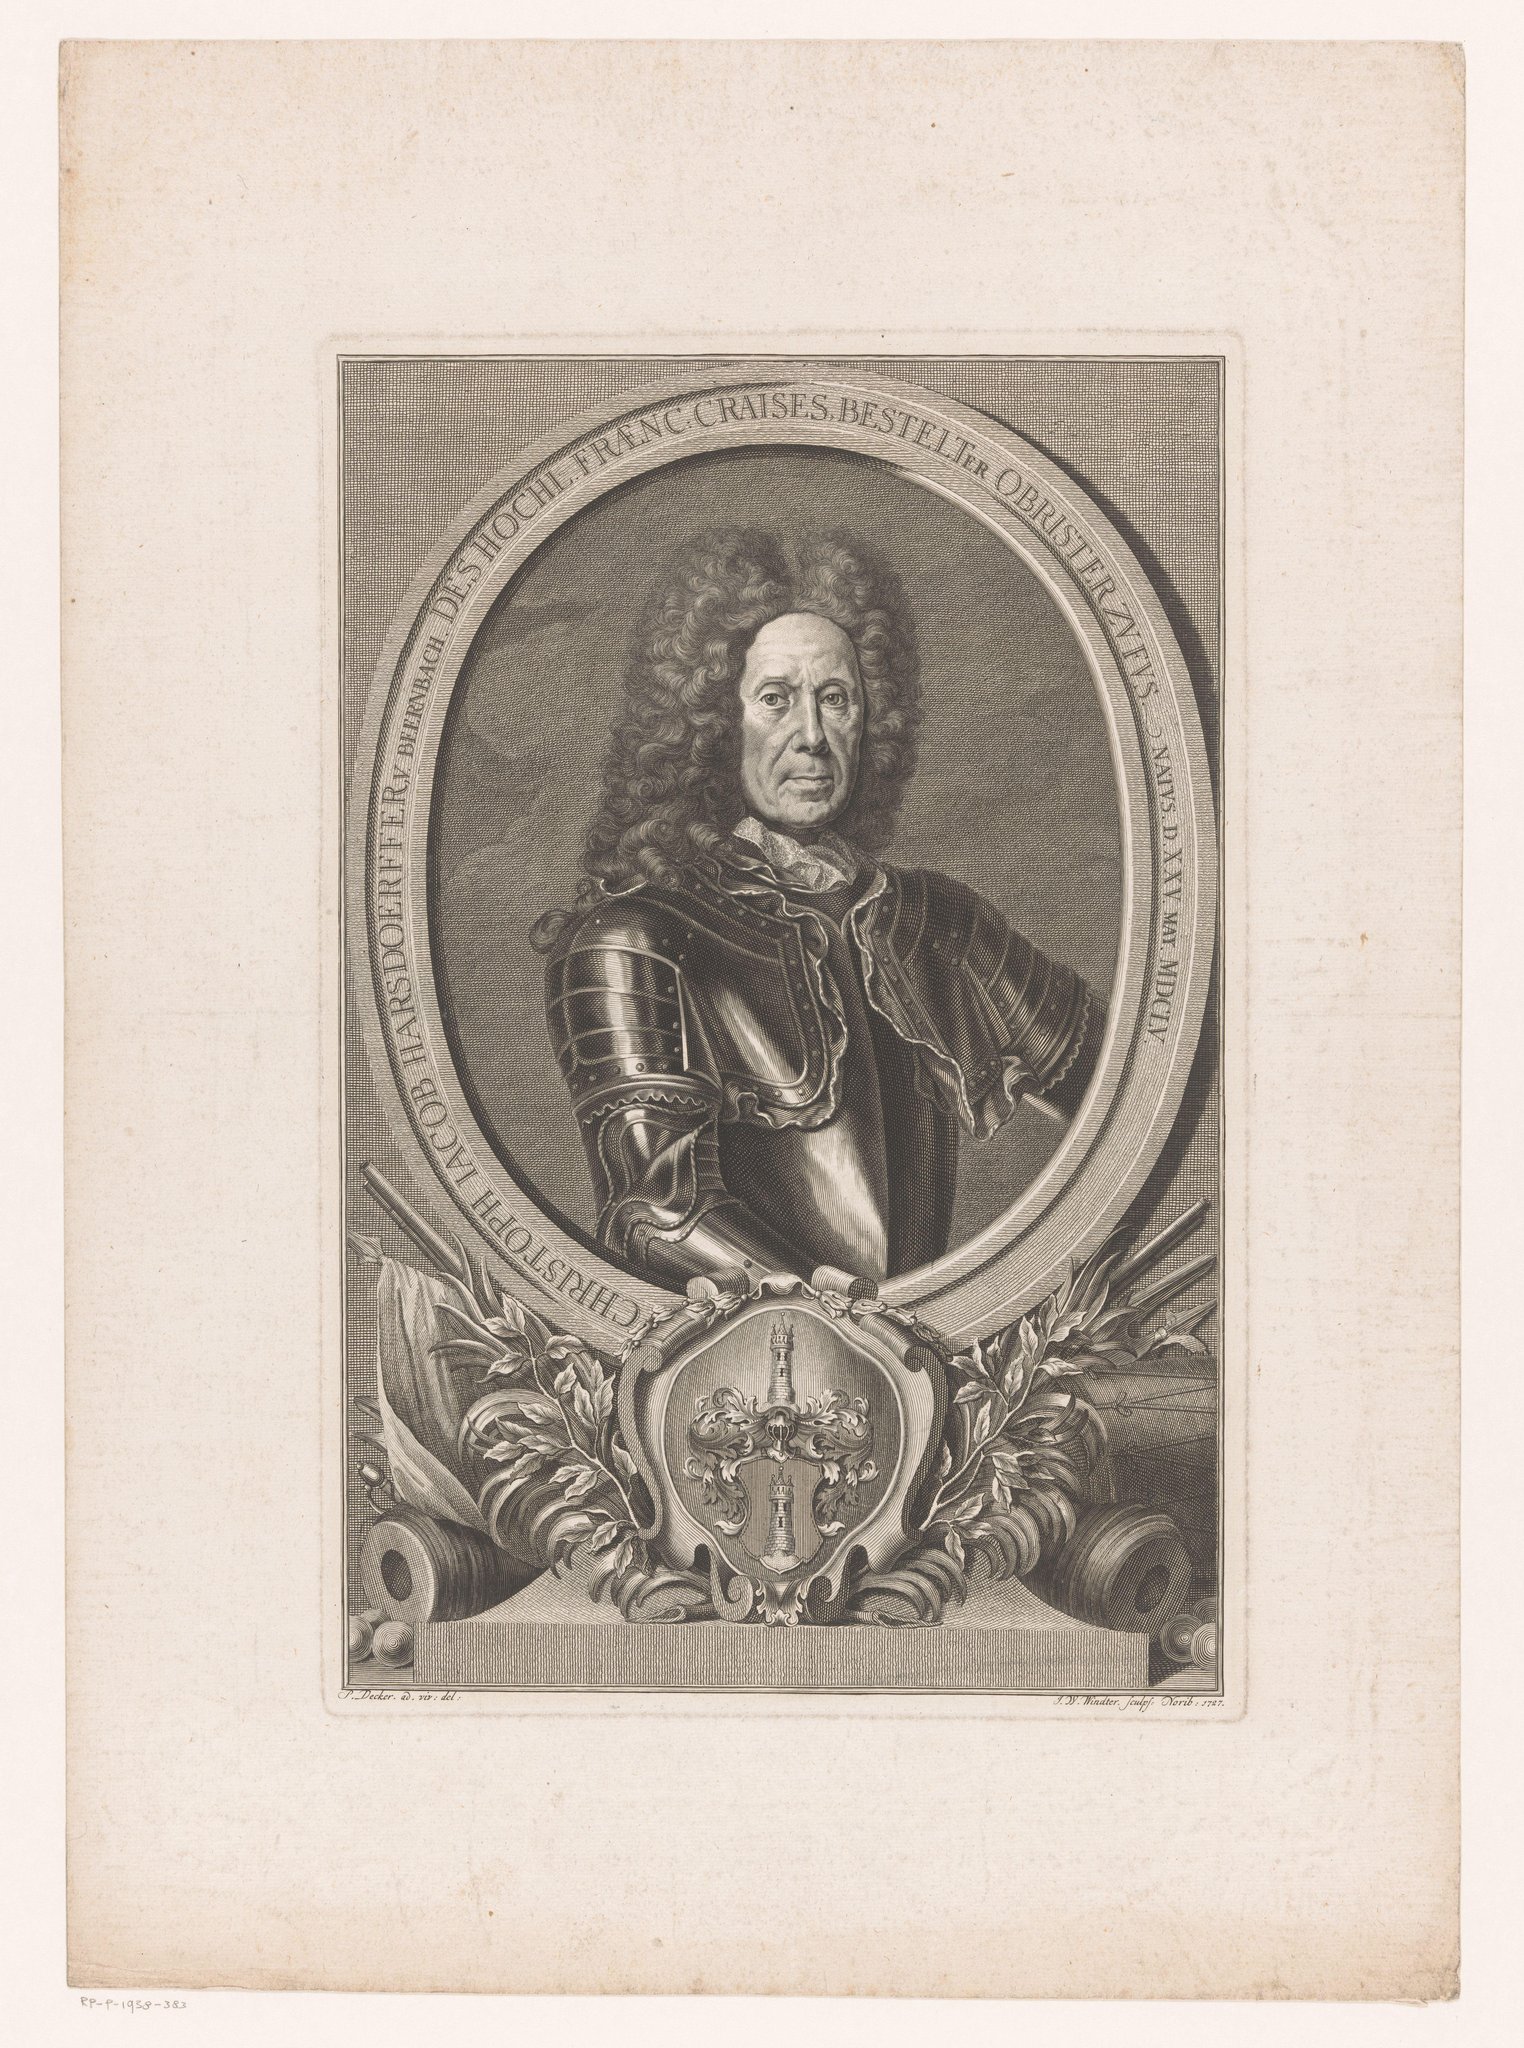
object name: print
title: Portret van Christoph Jacob Harsdörfer von Bernbach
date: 1727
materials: paper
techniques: engraving, etching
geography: nuremberg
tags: historical persons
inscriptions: collector's mark: Lugt 2228